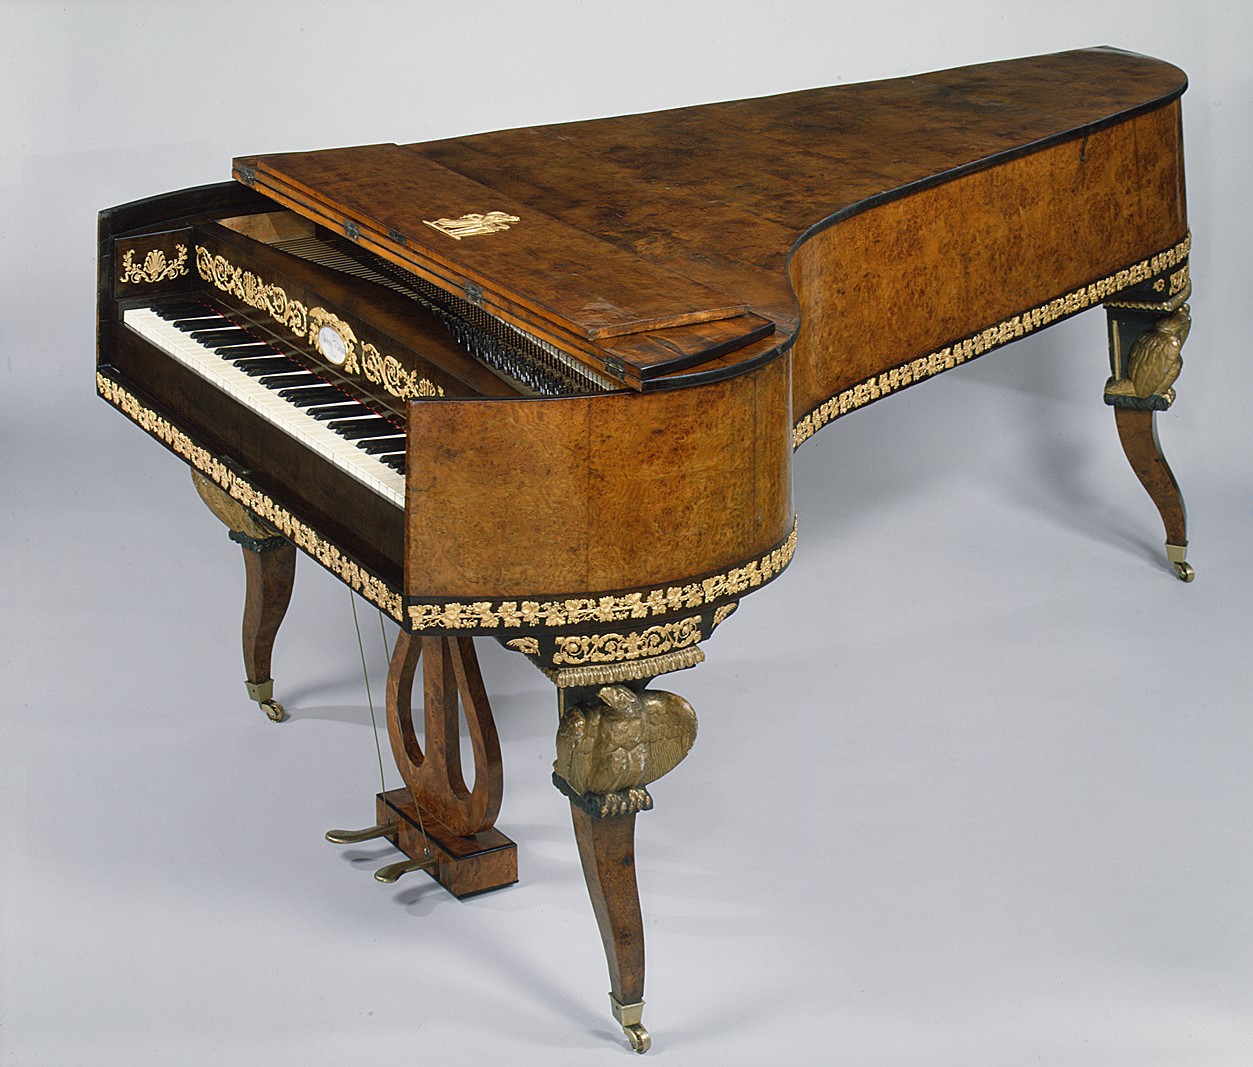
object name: grand piano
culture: austrian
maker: joseph böhm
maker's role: maker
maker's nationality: austrian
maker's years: 1786-1850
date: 1815-1820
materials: wood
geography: austria